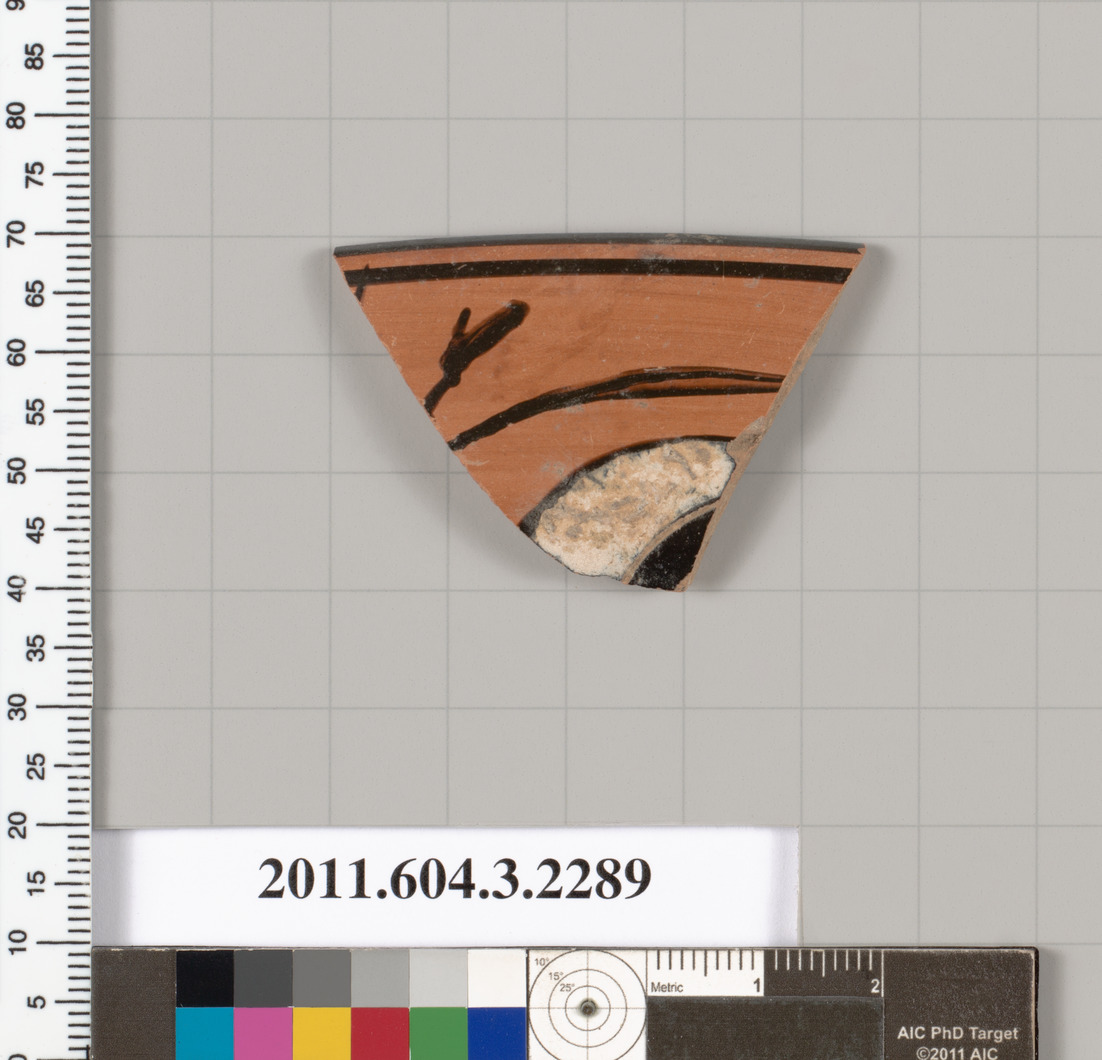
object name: kylix fragment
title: Terracotta rim fragment of a kylix: eye-cup (drinking cup)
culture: greek, attic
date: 540-500 BCE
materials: terracotta